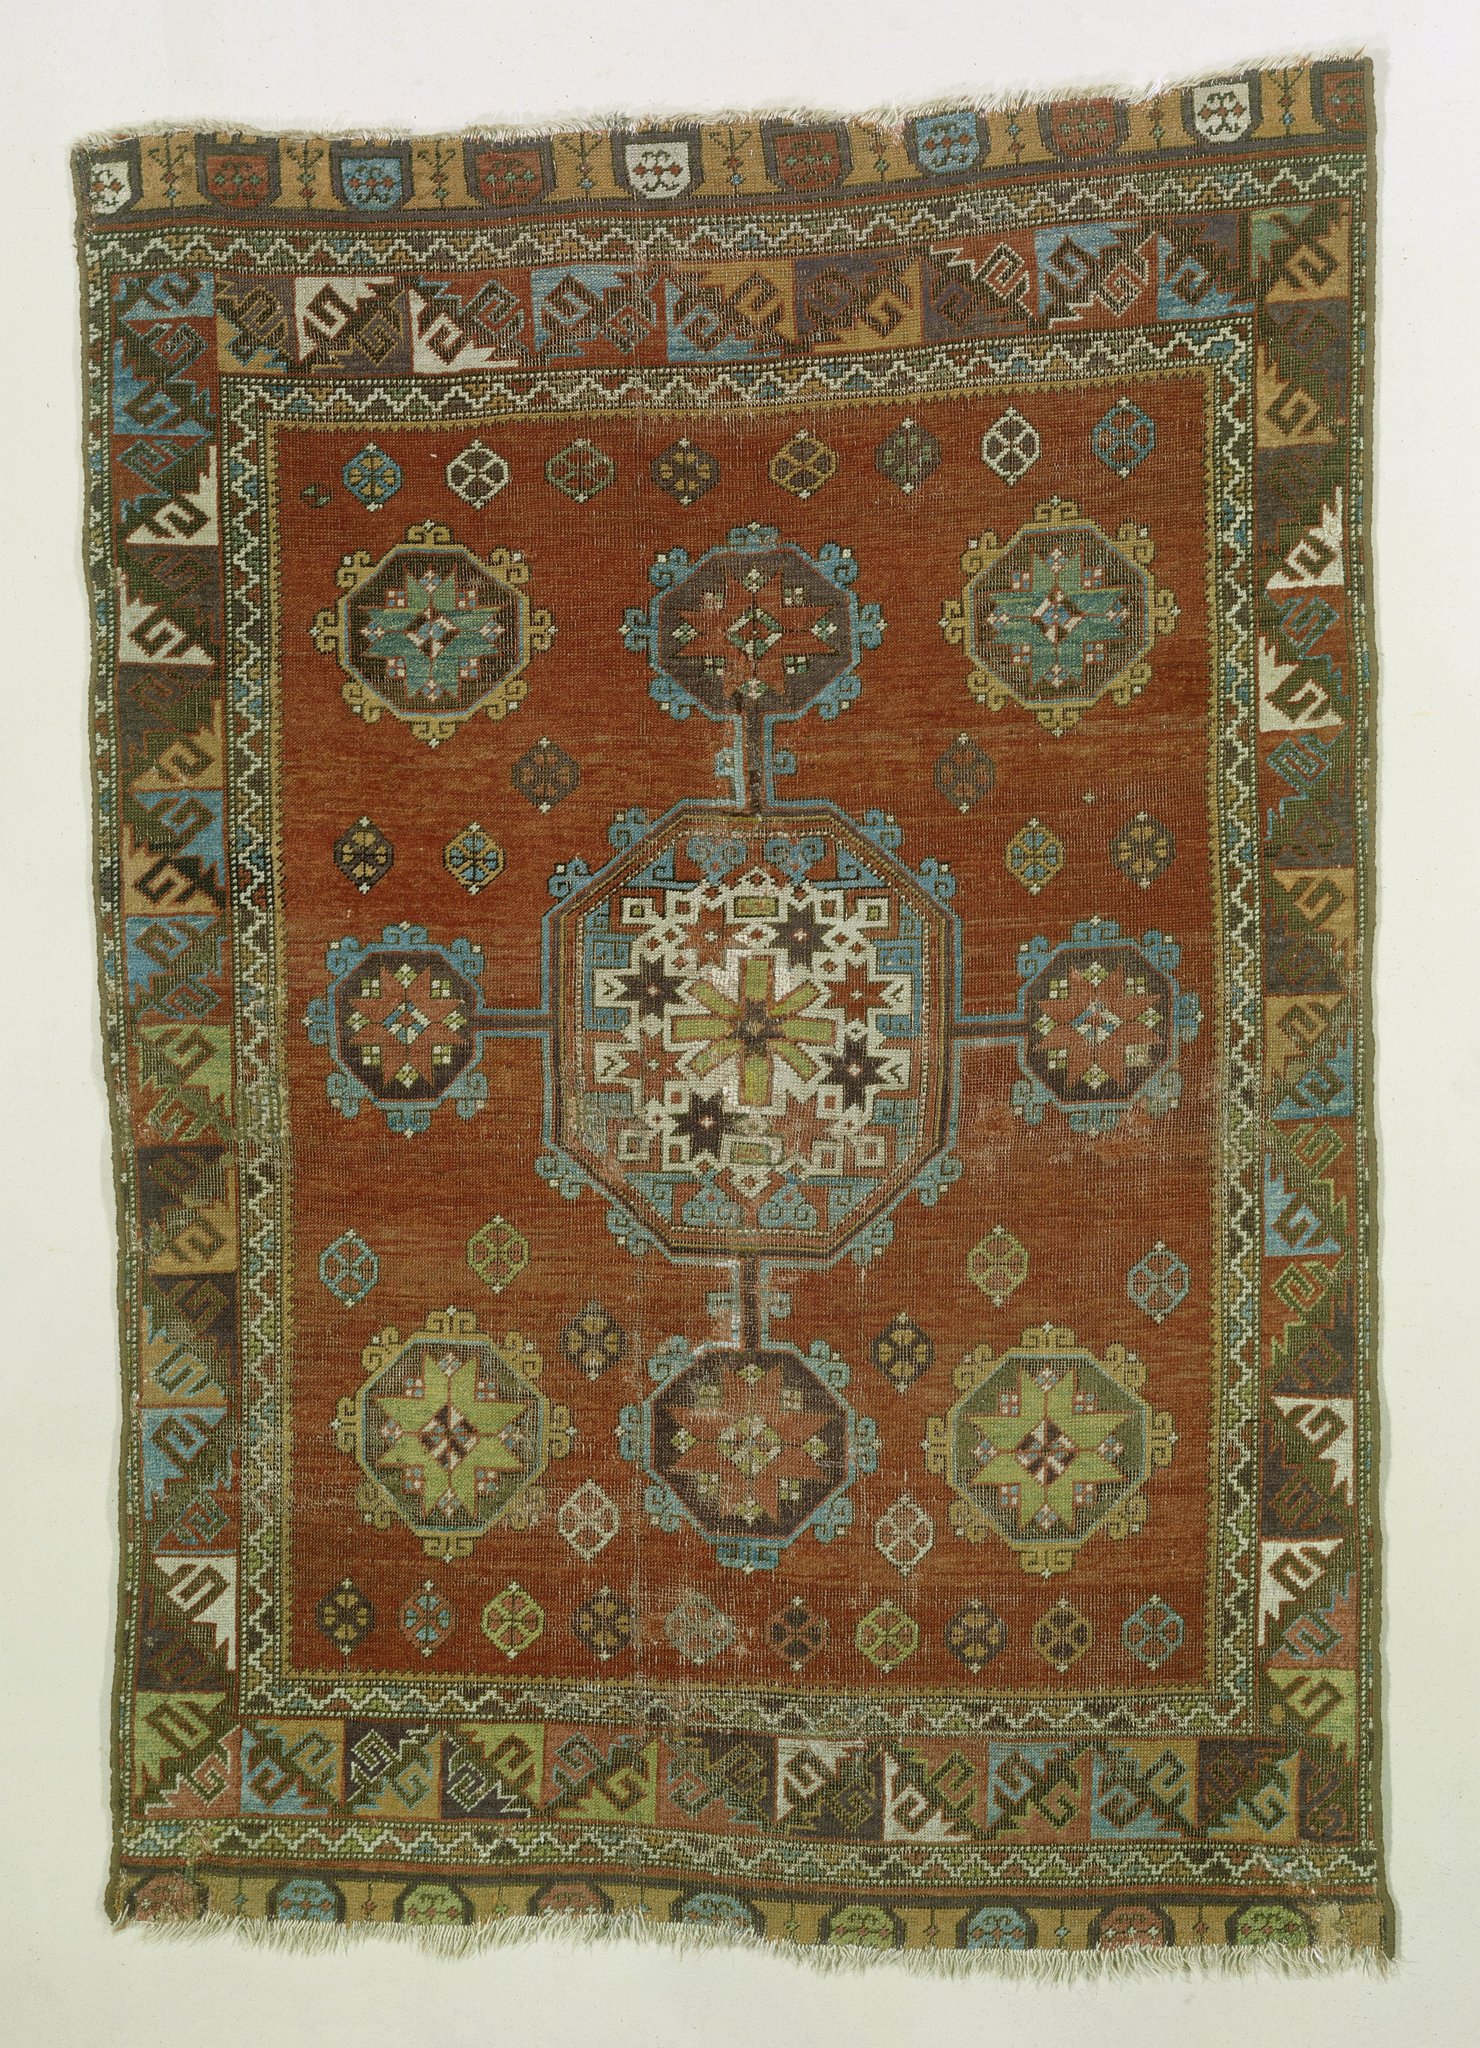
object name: oriental rug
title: Oosters tapijt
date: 1600-1800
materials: wool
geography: asia minor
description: Oosters tapijt, arabeskenkleed, lottotapijt. Bergama- of Holbeintapijt. In het middenveld een grote achthoek met kleinere daaromheen. Drie randen aan de zijden, vier boven en onderaan. Breedste rand met vierkanten. Knoop: Ghiordes knoop.